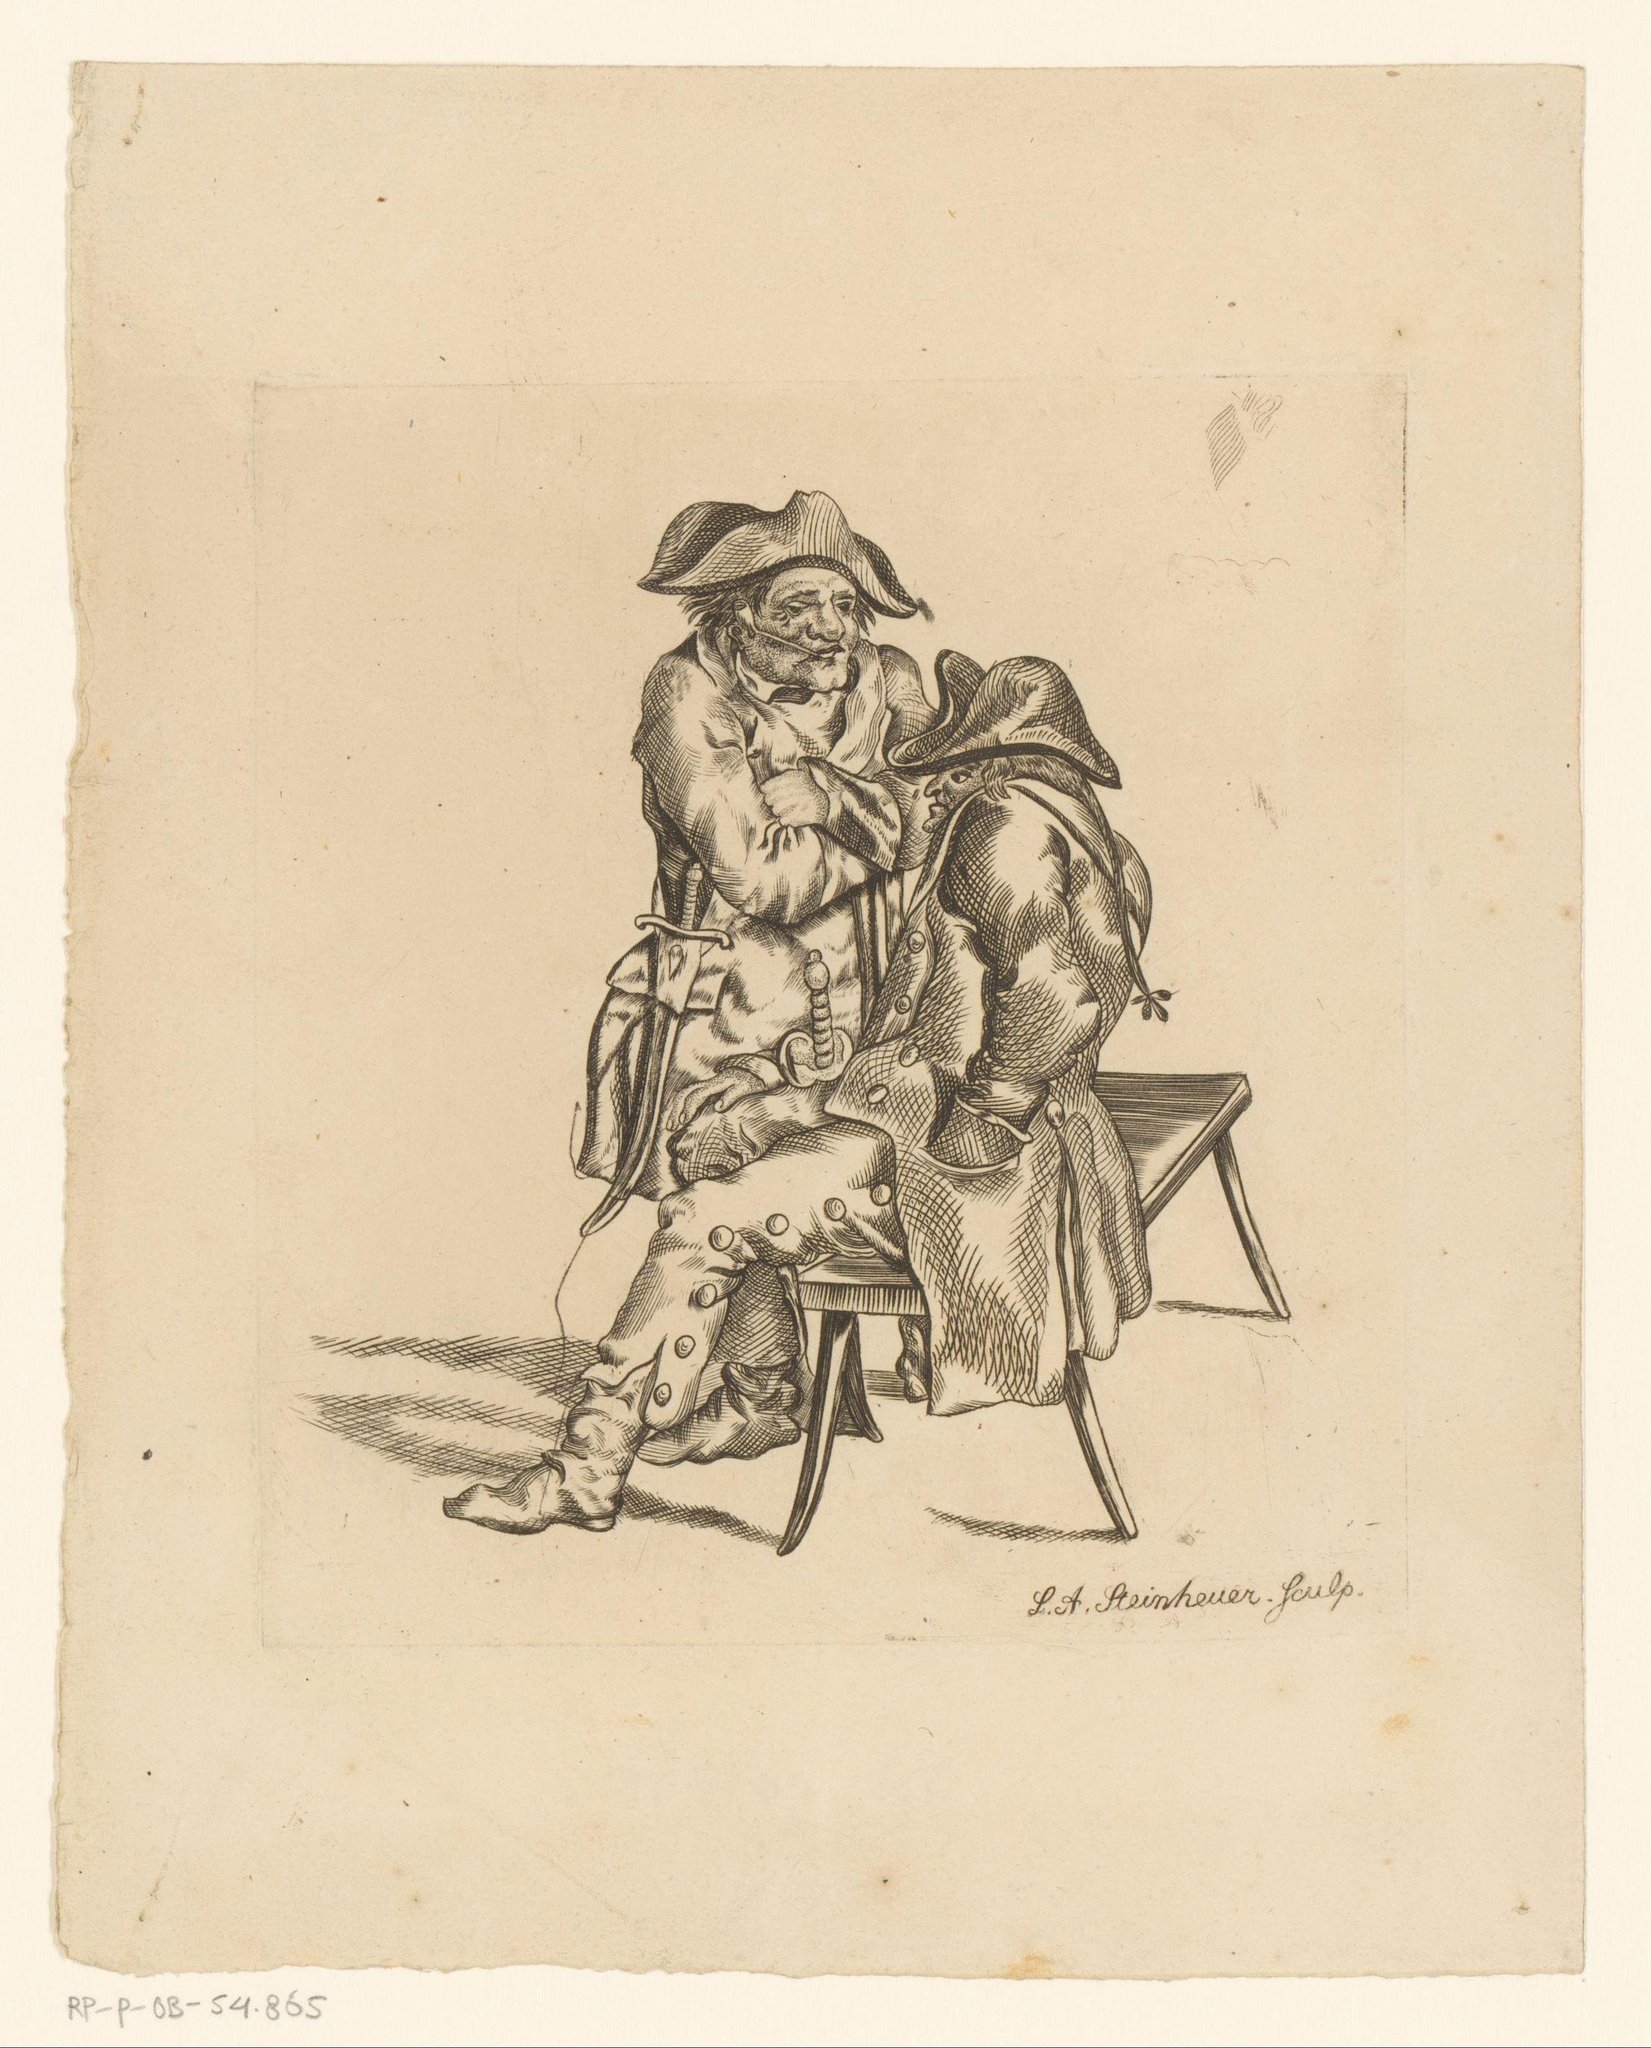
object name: print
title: Man zittend op een bank en staande man met pijp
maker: l.a. steinheuer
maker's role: print maker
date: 1800-1899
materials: paper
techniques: engraving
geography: germany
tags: sitting figure, pipe ~ tobacco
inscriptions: collector's mark: Lugt 2228